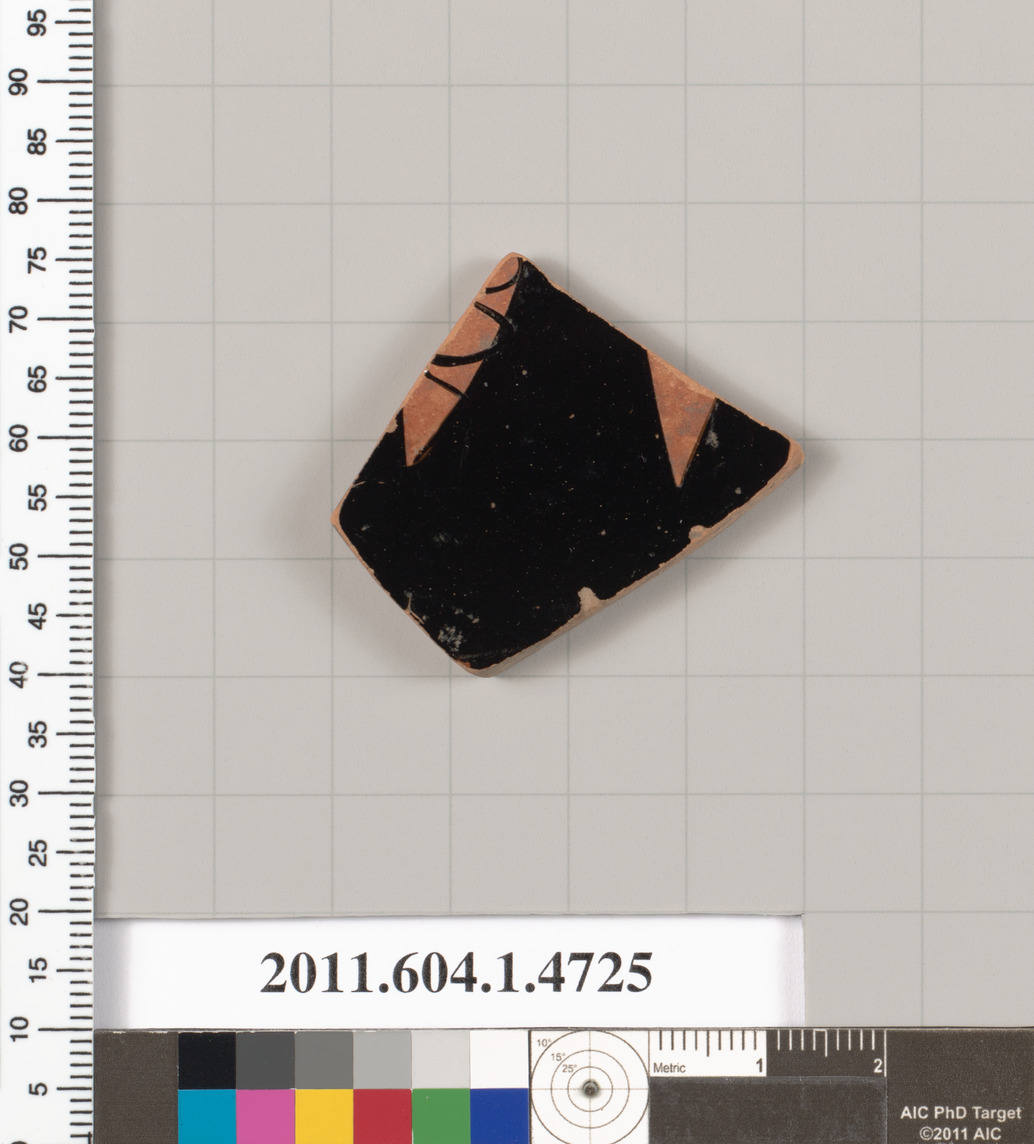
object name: kylix fragment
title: Terracotta fragment of a kylix (drinking cup)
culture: greek, attic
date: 500-470 BCE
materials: terracotta